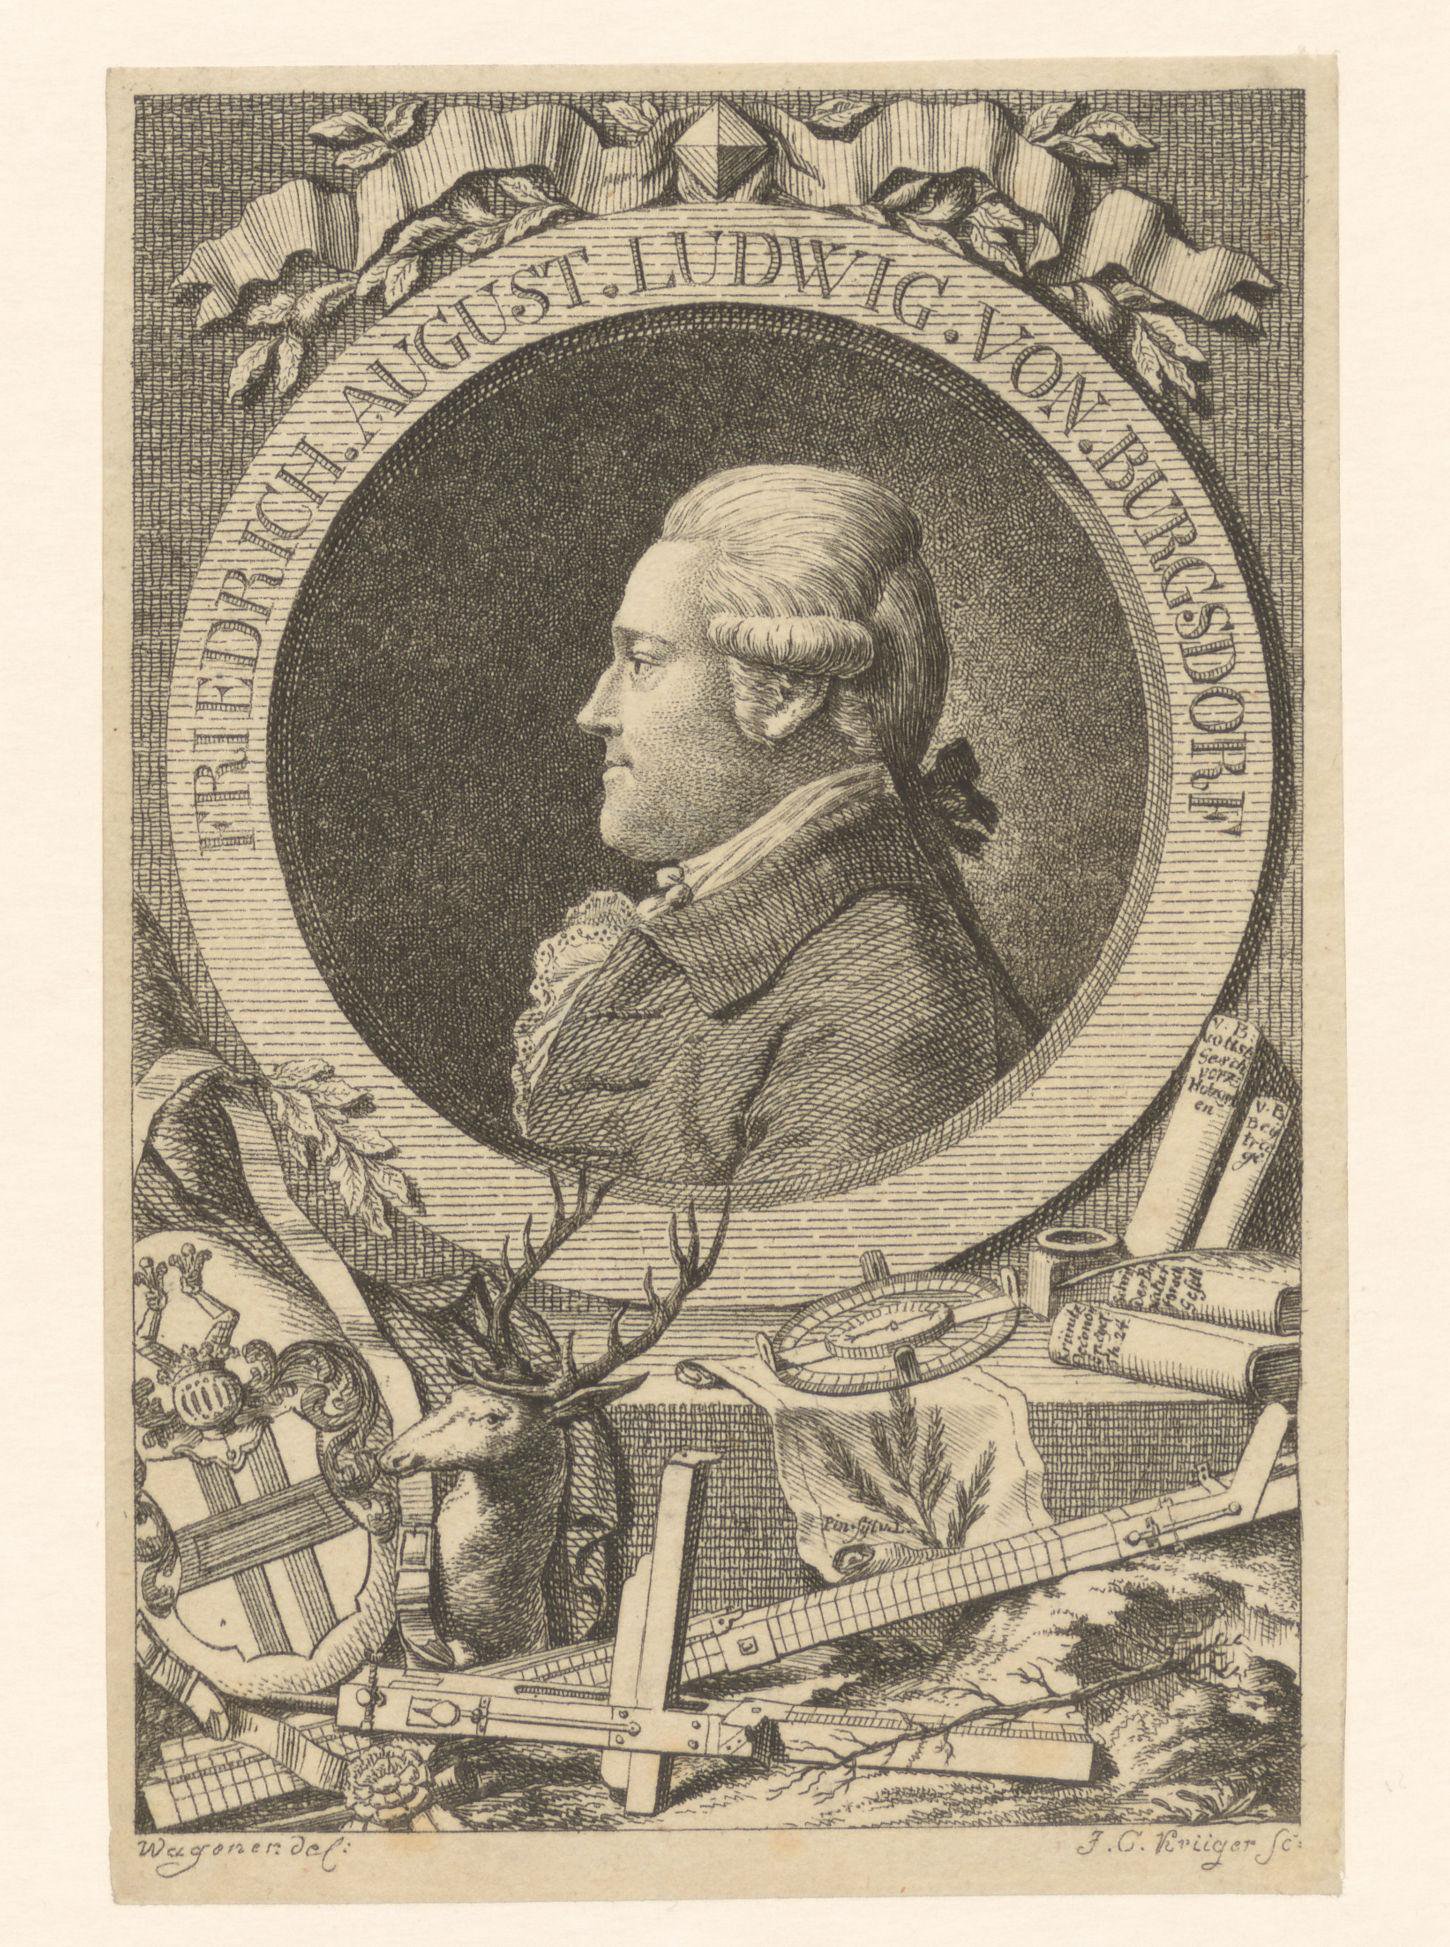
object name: print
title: Portret van Friedrich August Ludwig von Burgsdorf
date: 1759-1791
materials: paper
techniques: engraving, etching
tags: berlin, coat of arms (as symbol of the state, etc.), aspects of science in general (+ tools, instruments; laboratory equipment ~ scientific research), botany (+ portrait of scholar, scientist), historical persons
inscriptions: collector's mark: Lugt 2228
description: Tekst in het Duits op de kaften van de boeken in de voorstelling.